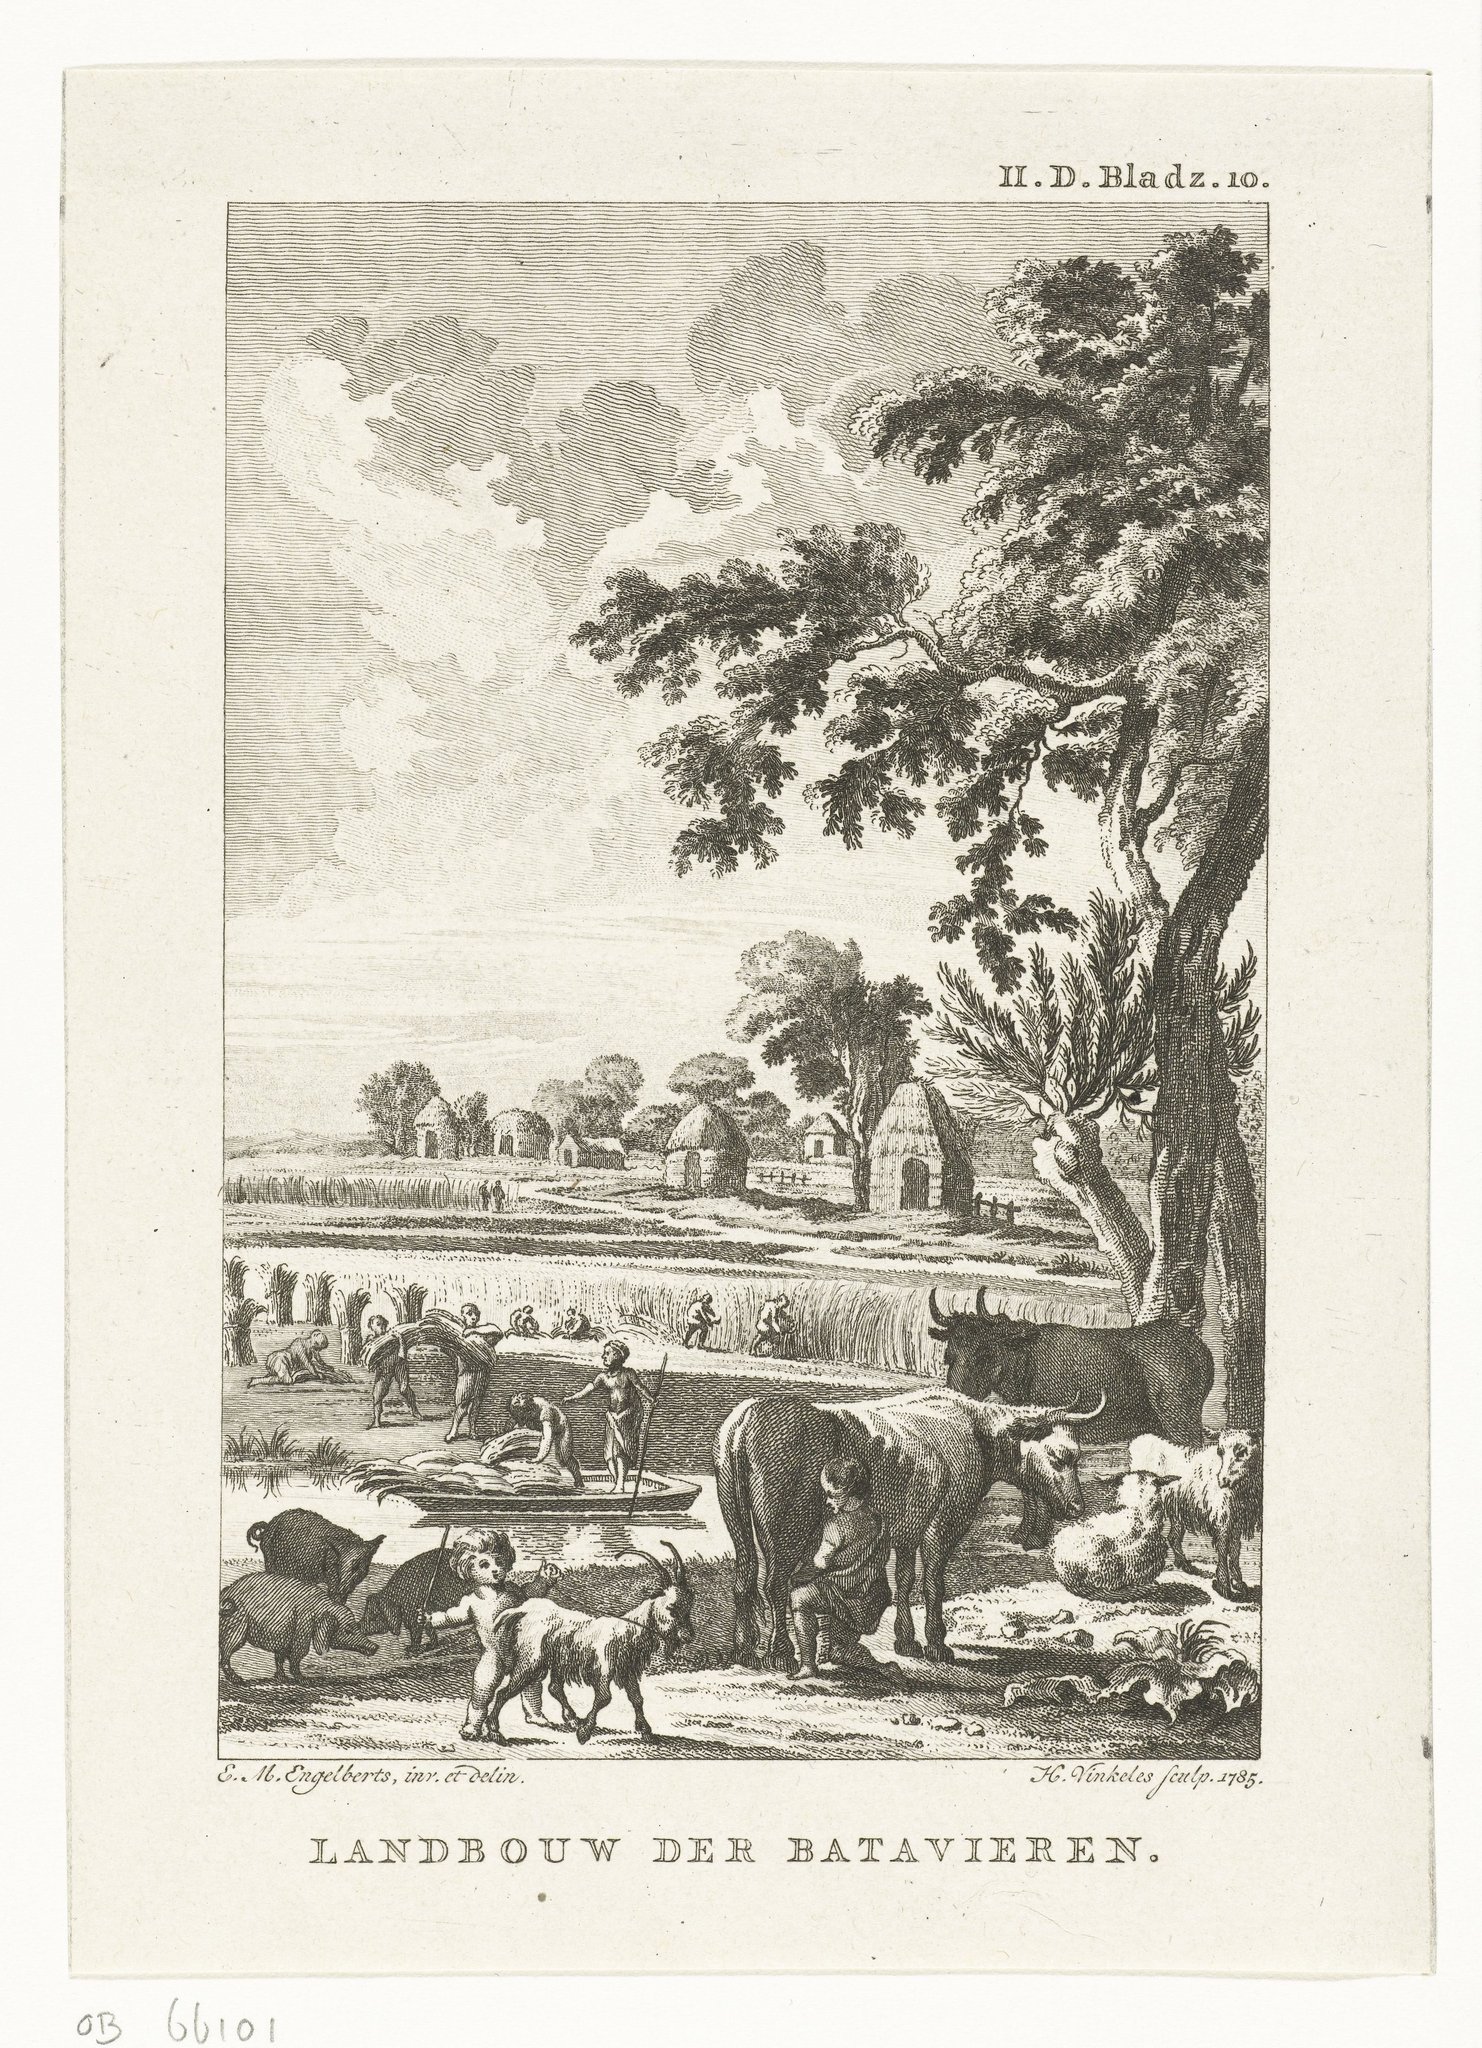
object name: book illustration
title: Veeteelt en landbouw bij de Bataven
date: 1785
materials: paper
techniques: etching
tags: extinct, 'historical' peoples (with name), netherlands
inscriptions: collector's mark: Lugt 2228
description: Prent gebruikt als boekillustratie in: Engelberts, Engelbertus Matthias. De aloude staat en geschiedenissen der Vereenigde Nederlanden. Amsterdam: Johannes Allart, 1784-1799. Deel II, 1785.